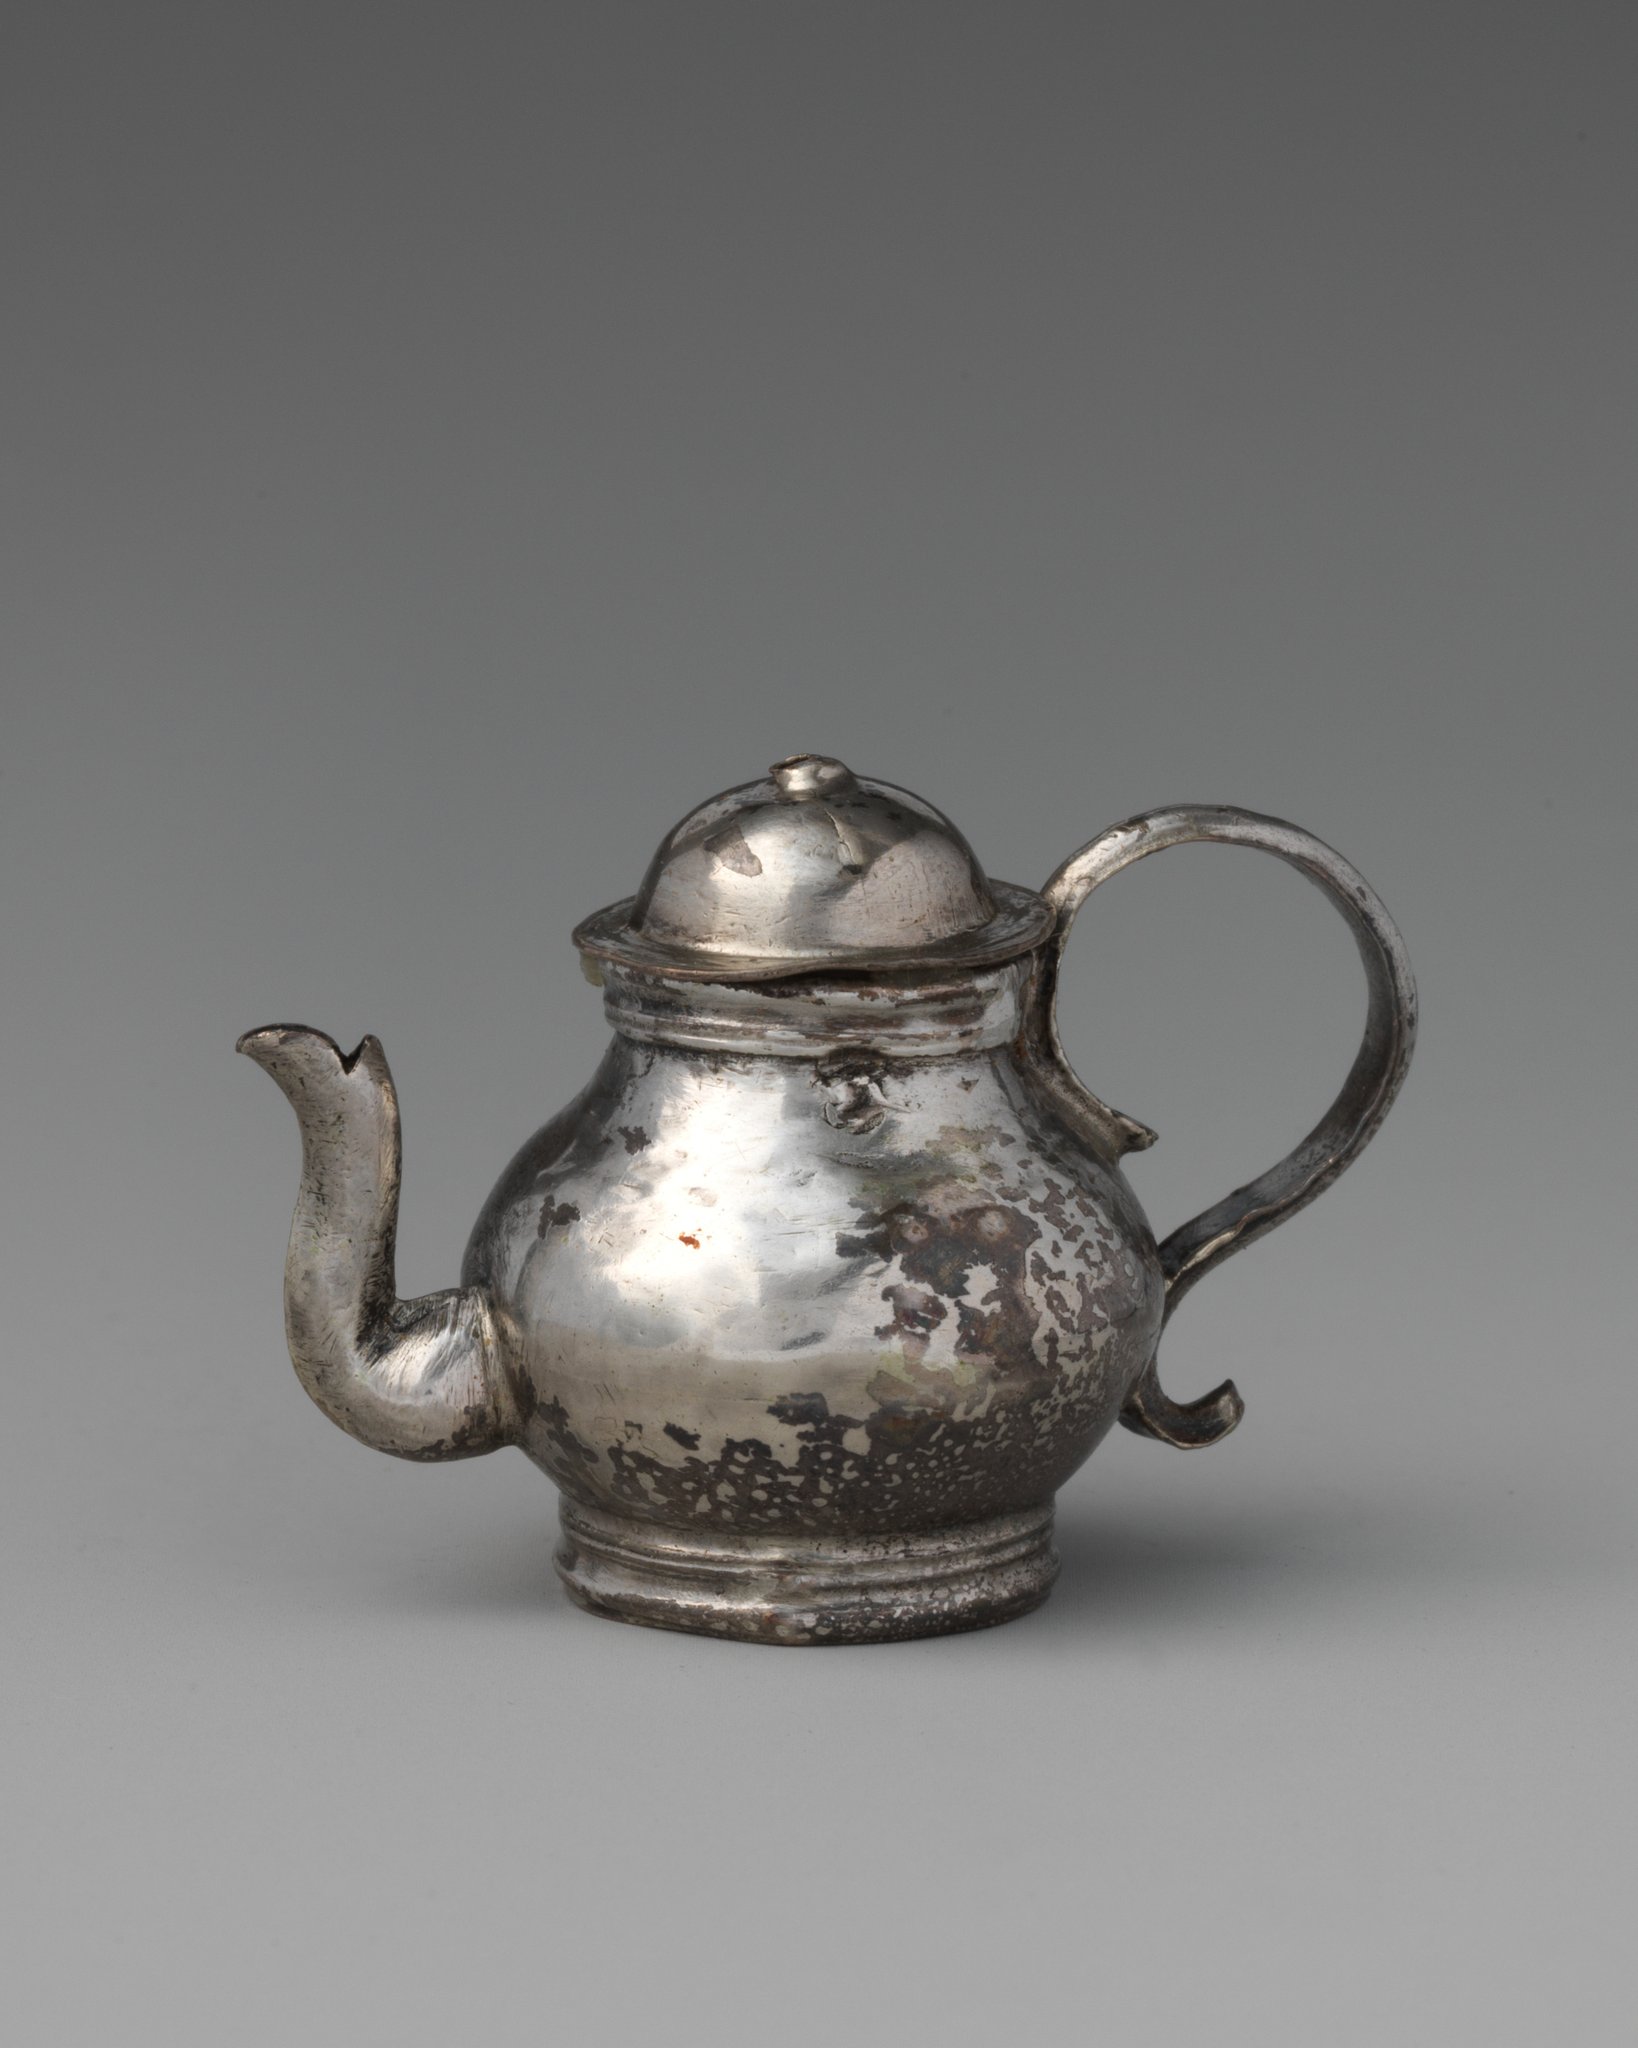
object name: teapot with cover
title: Miniature teapot with cover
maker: david clayton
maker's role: maker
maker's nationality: british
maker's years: 1659-1719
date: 1667-1733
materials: silver